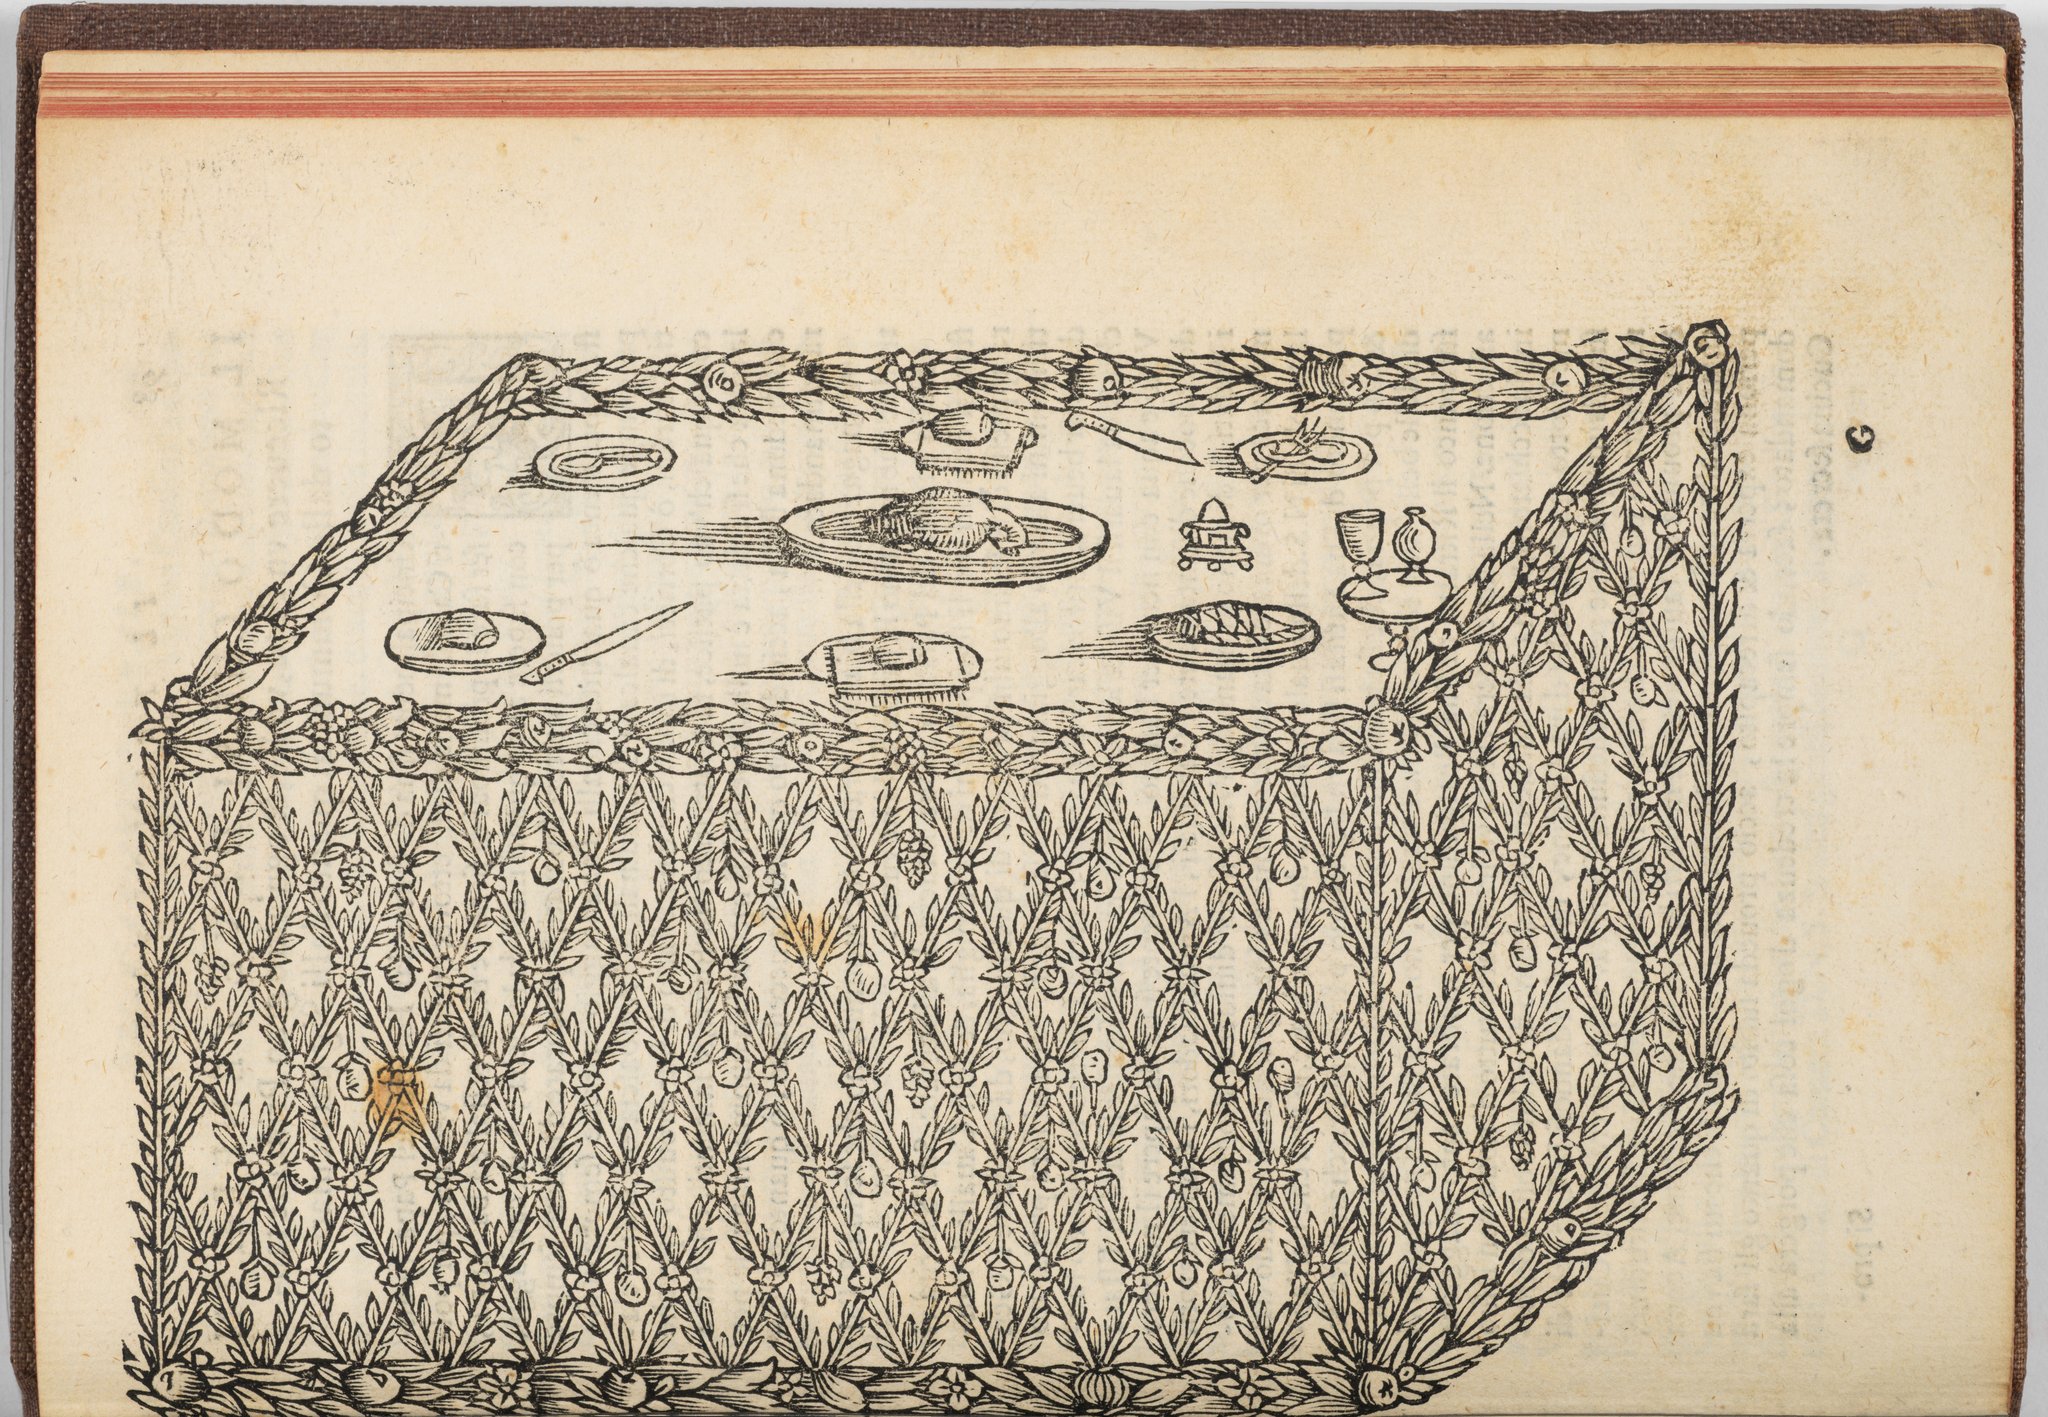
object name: book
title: Il Trinciante. . .Ampliato et Perfettione ridoto dal Cavalier Reale Fusoritto da Narni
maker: vincenzo cervio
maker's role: author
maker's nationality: italian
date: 1593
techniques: woodcut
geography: italy